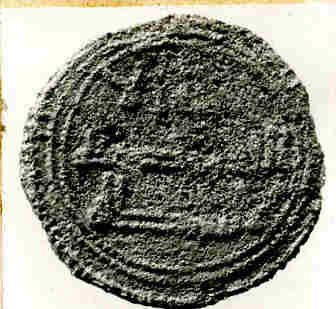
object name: coin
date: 701-900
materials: copper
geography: iran